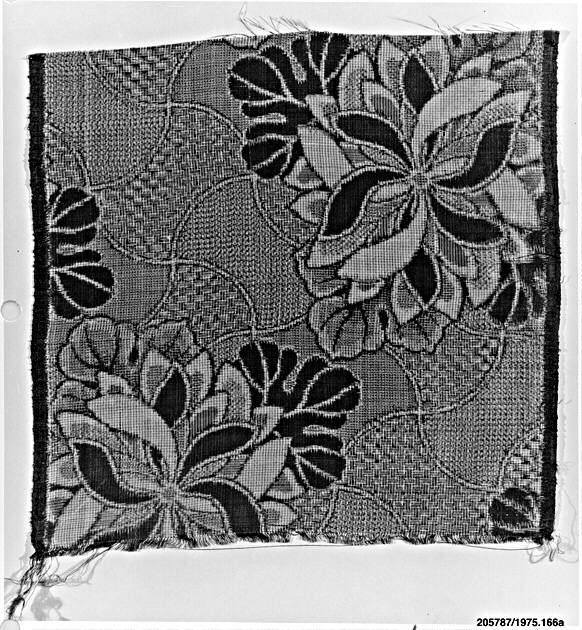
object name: piece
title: Two Pieces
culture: japanese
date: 1801-2000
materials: silk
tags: flowers